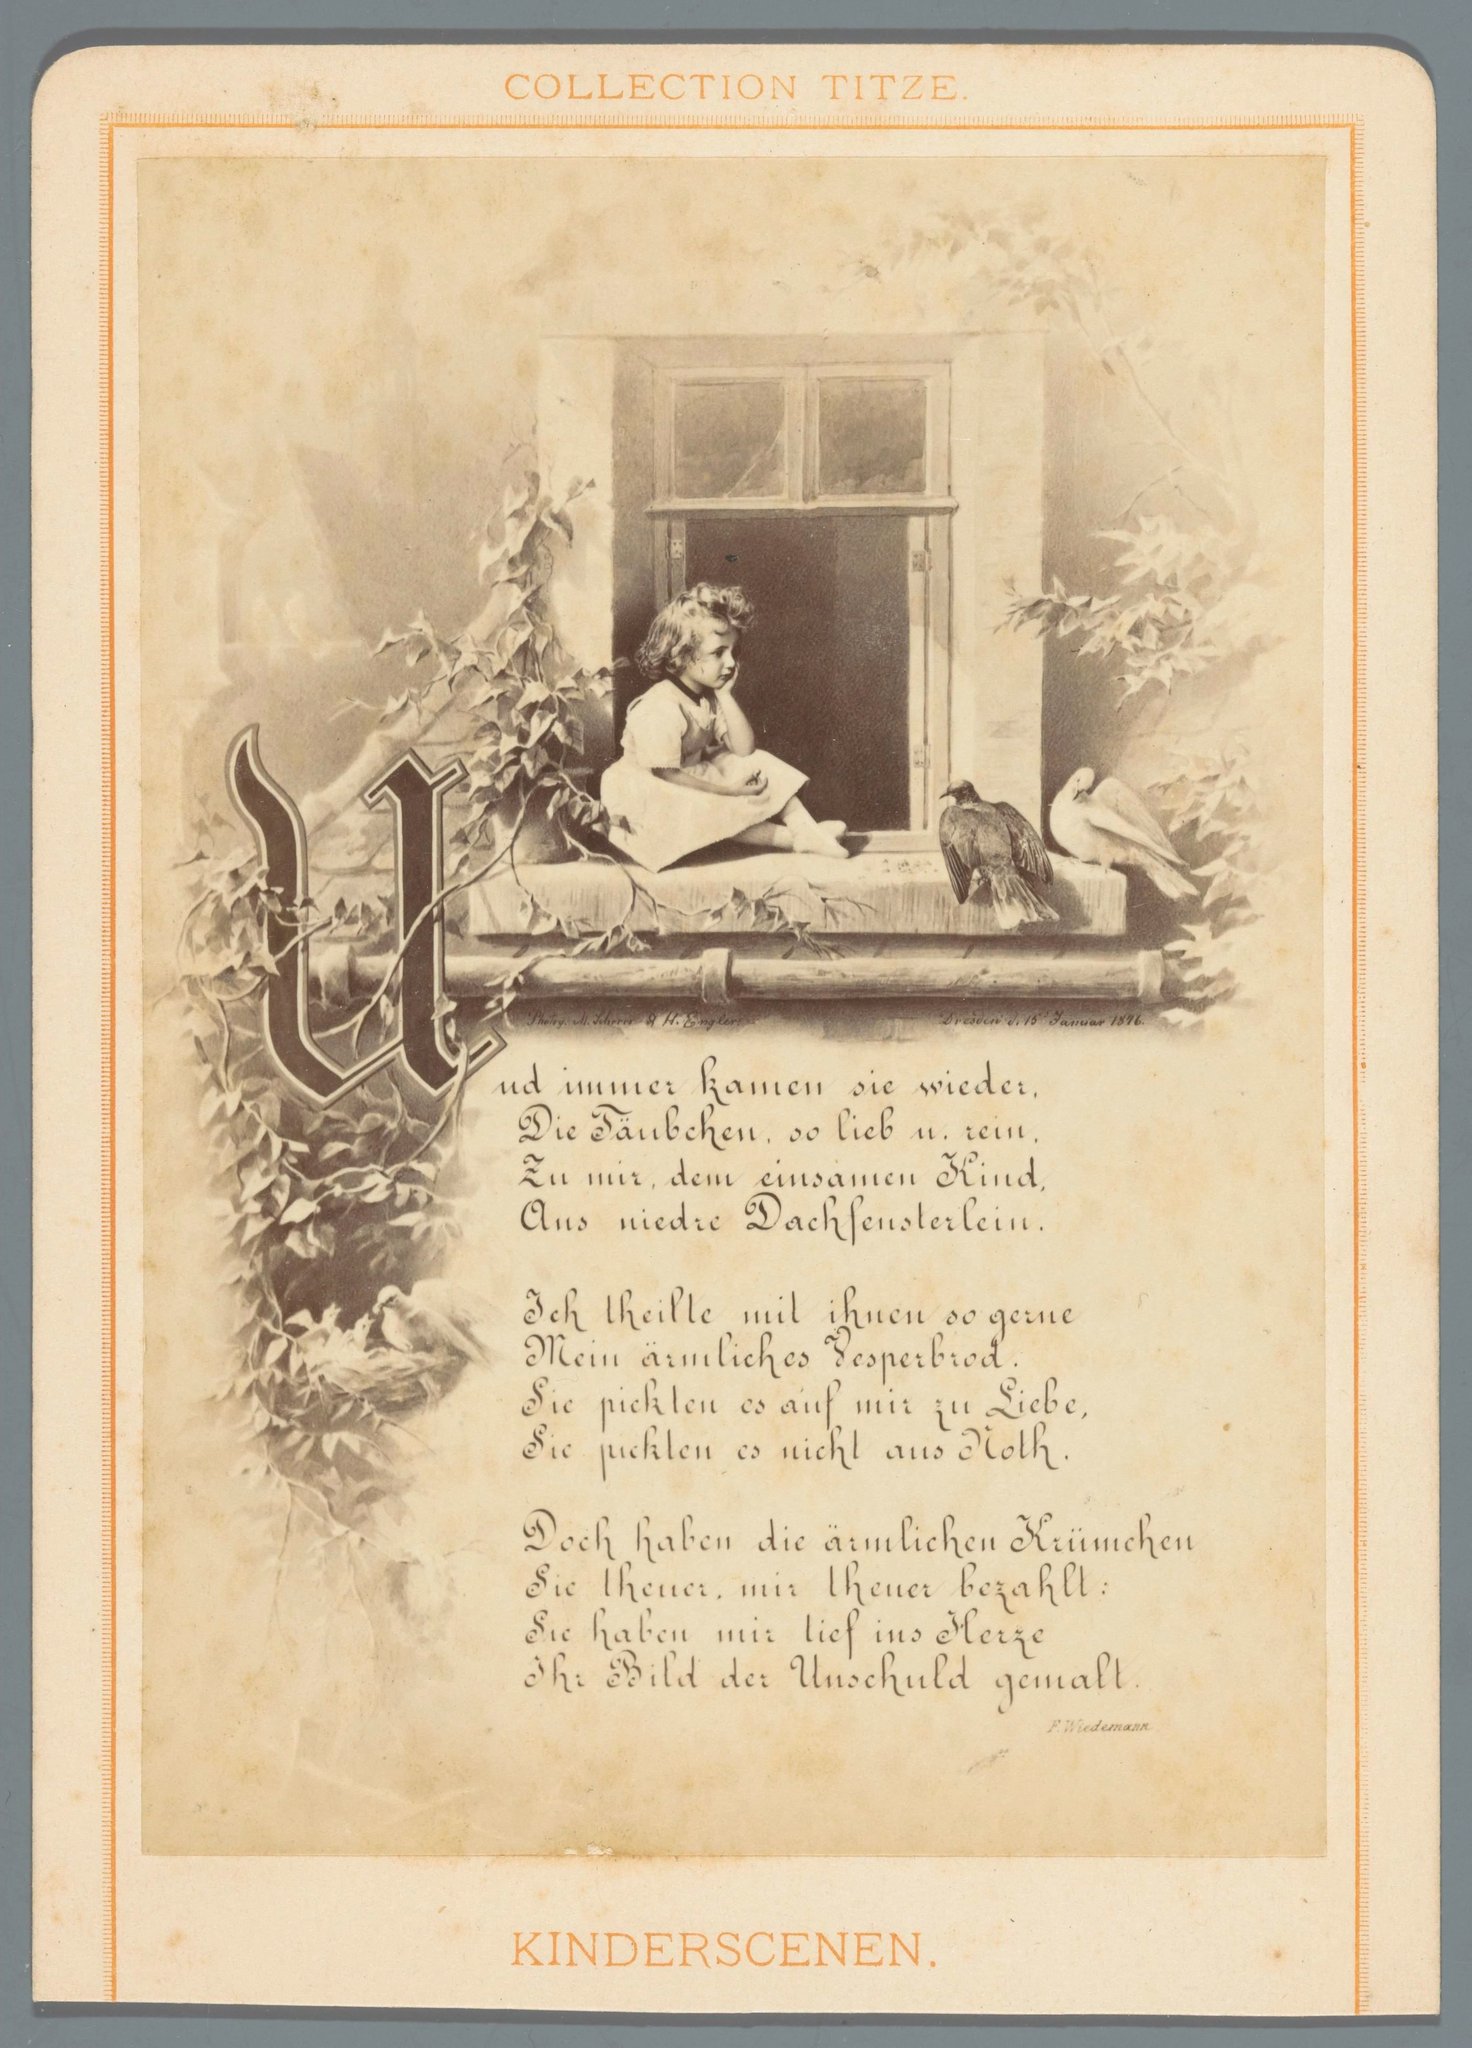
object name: reproduction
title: Kinderscenen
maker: Anonymous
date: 1875-1890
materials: cardboard, photographic support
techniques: albumen print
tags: child, open window, doves, pigeons